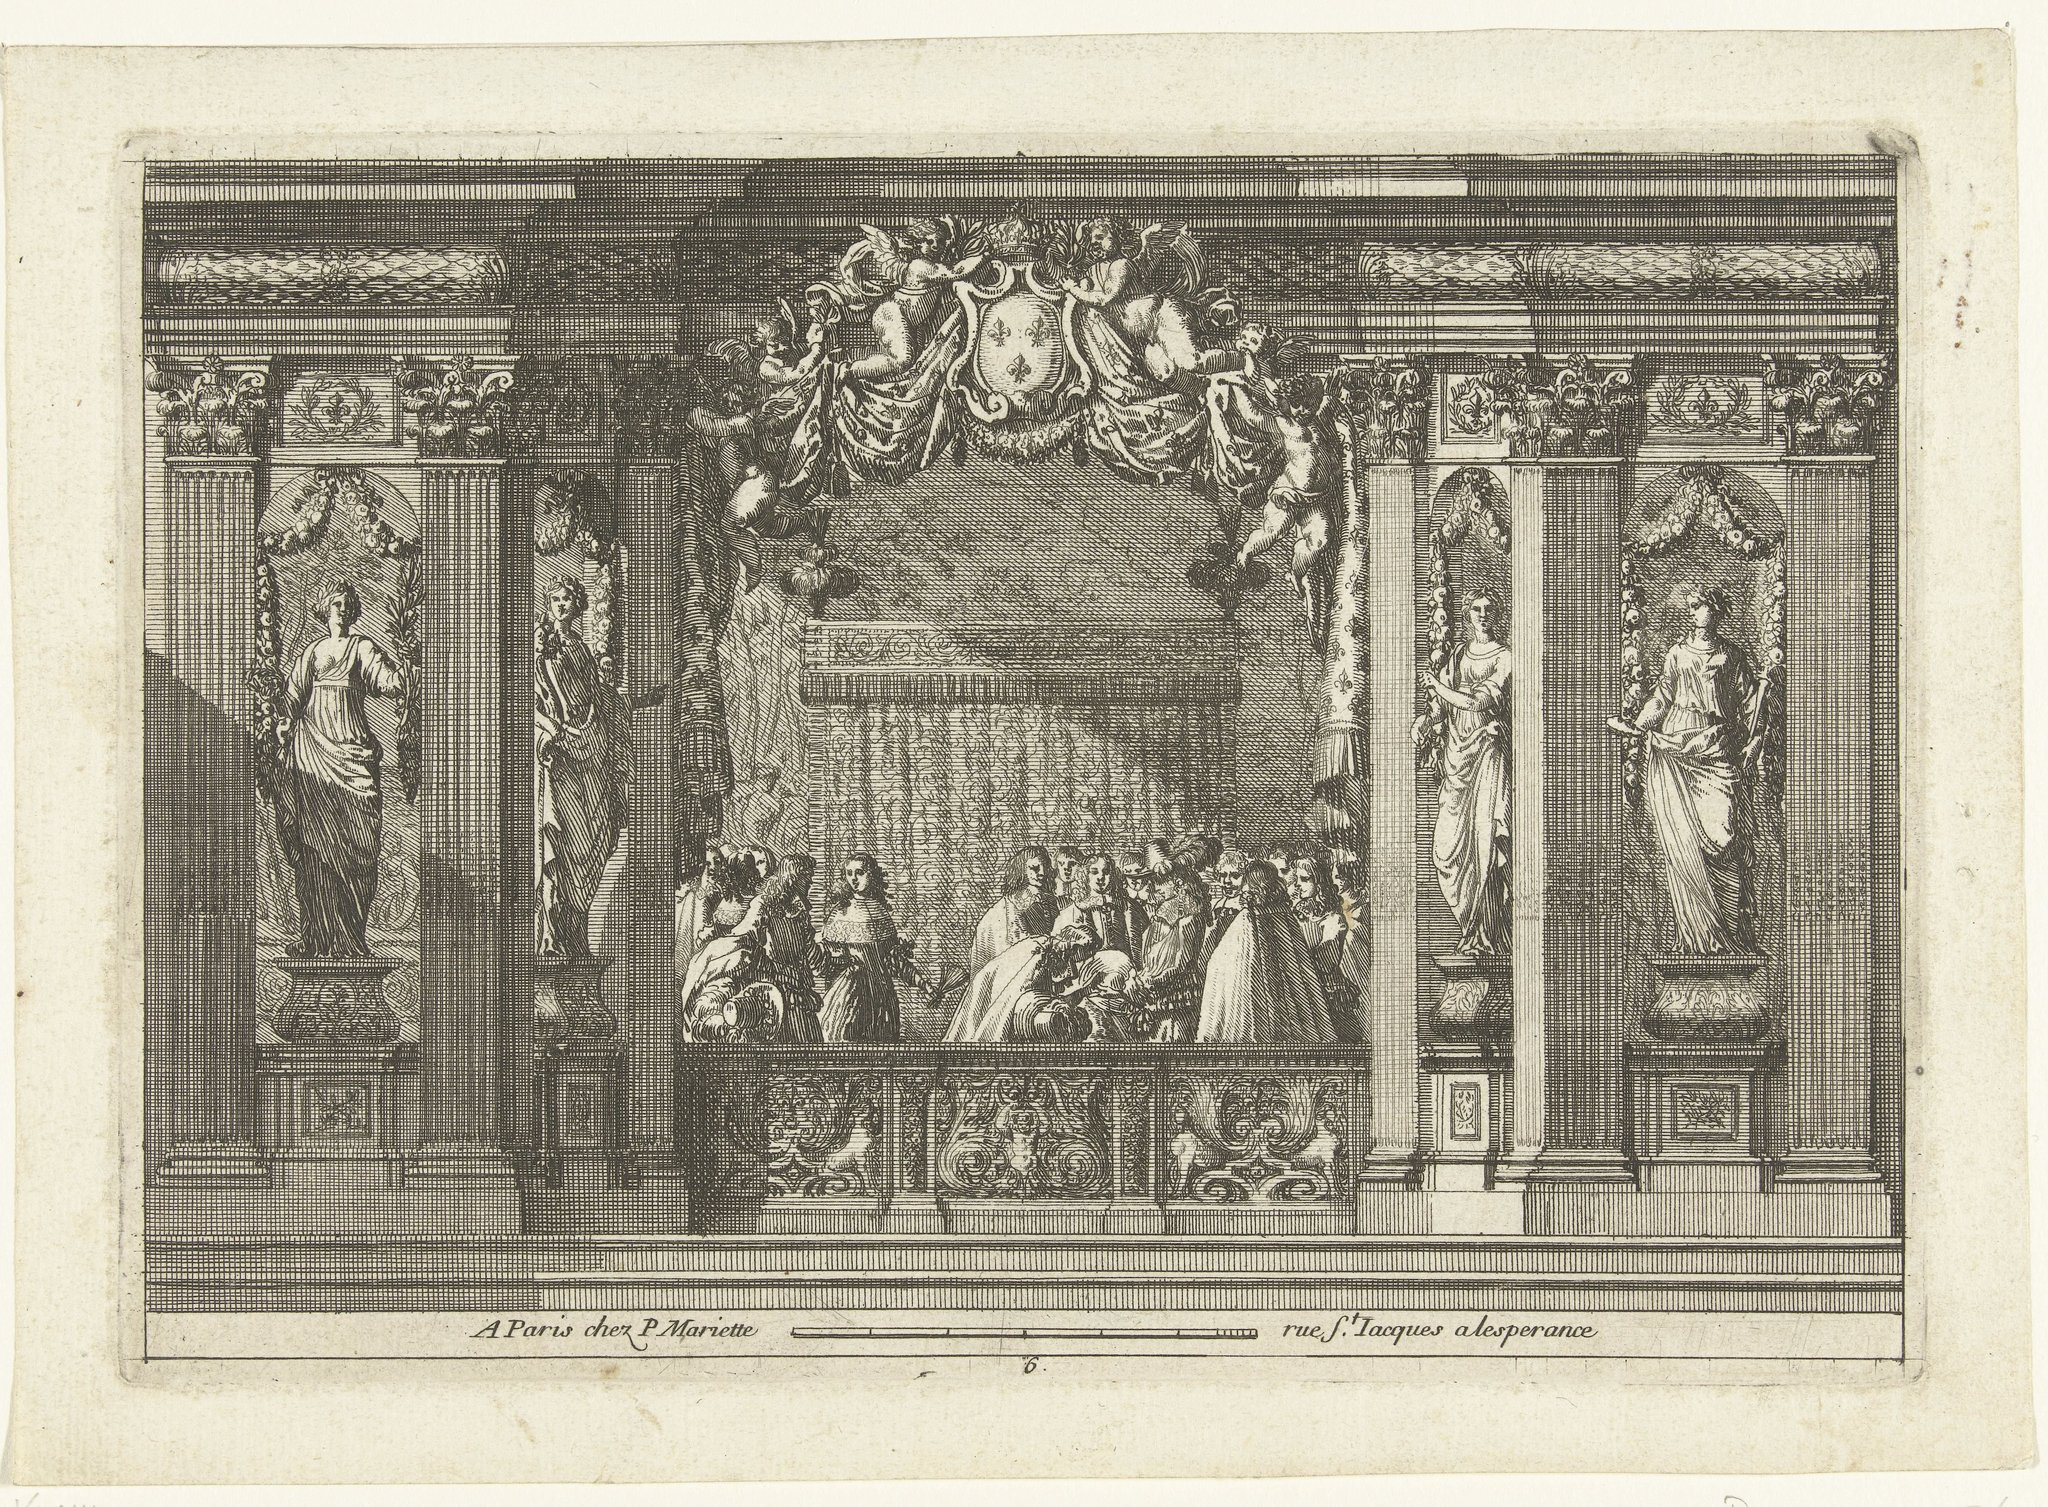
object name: ornament print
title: Alkoof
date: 1656-1657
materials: paper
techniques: etching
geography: france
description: Op de kroonlijst bevindt zich een cartouche met bekroond Frans koninklijk wapenschild. Voor het hemelbed staat de koning omringd door hovelingen. Derde afdruk uit tweede editie.